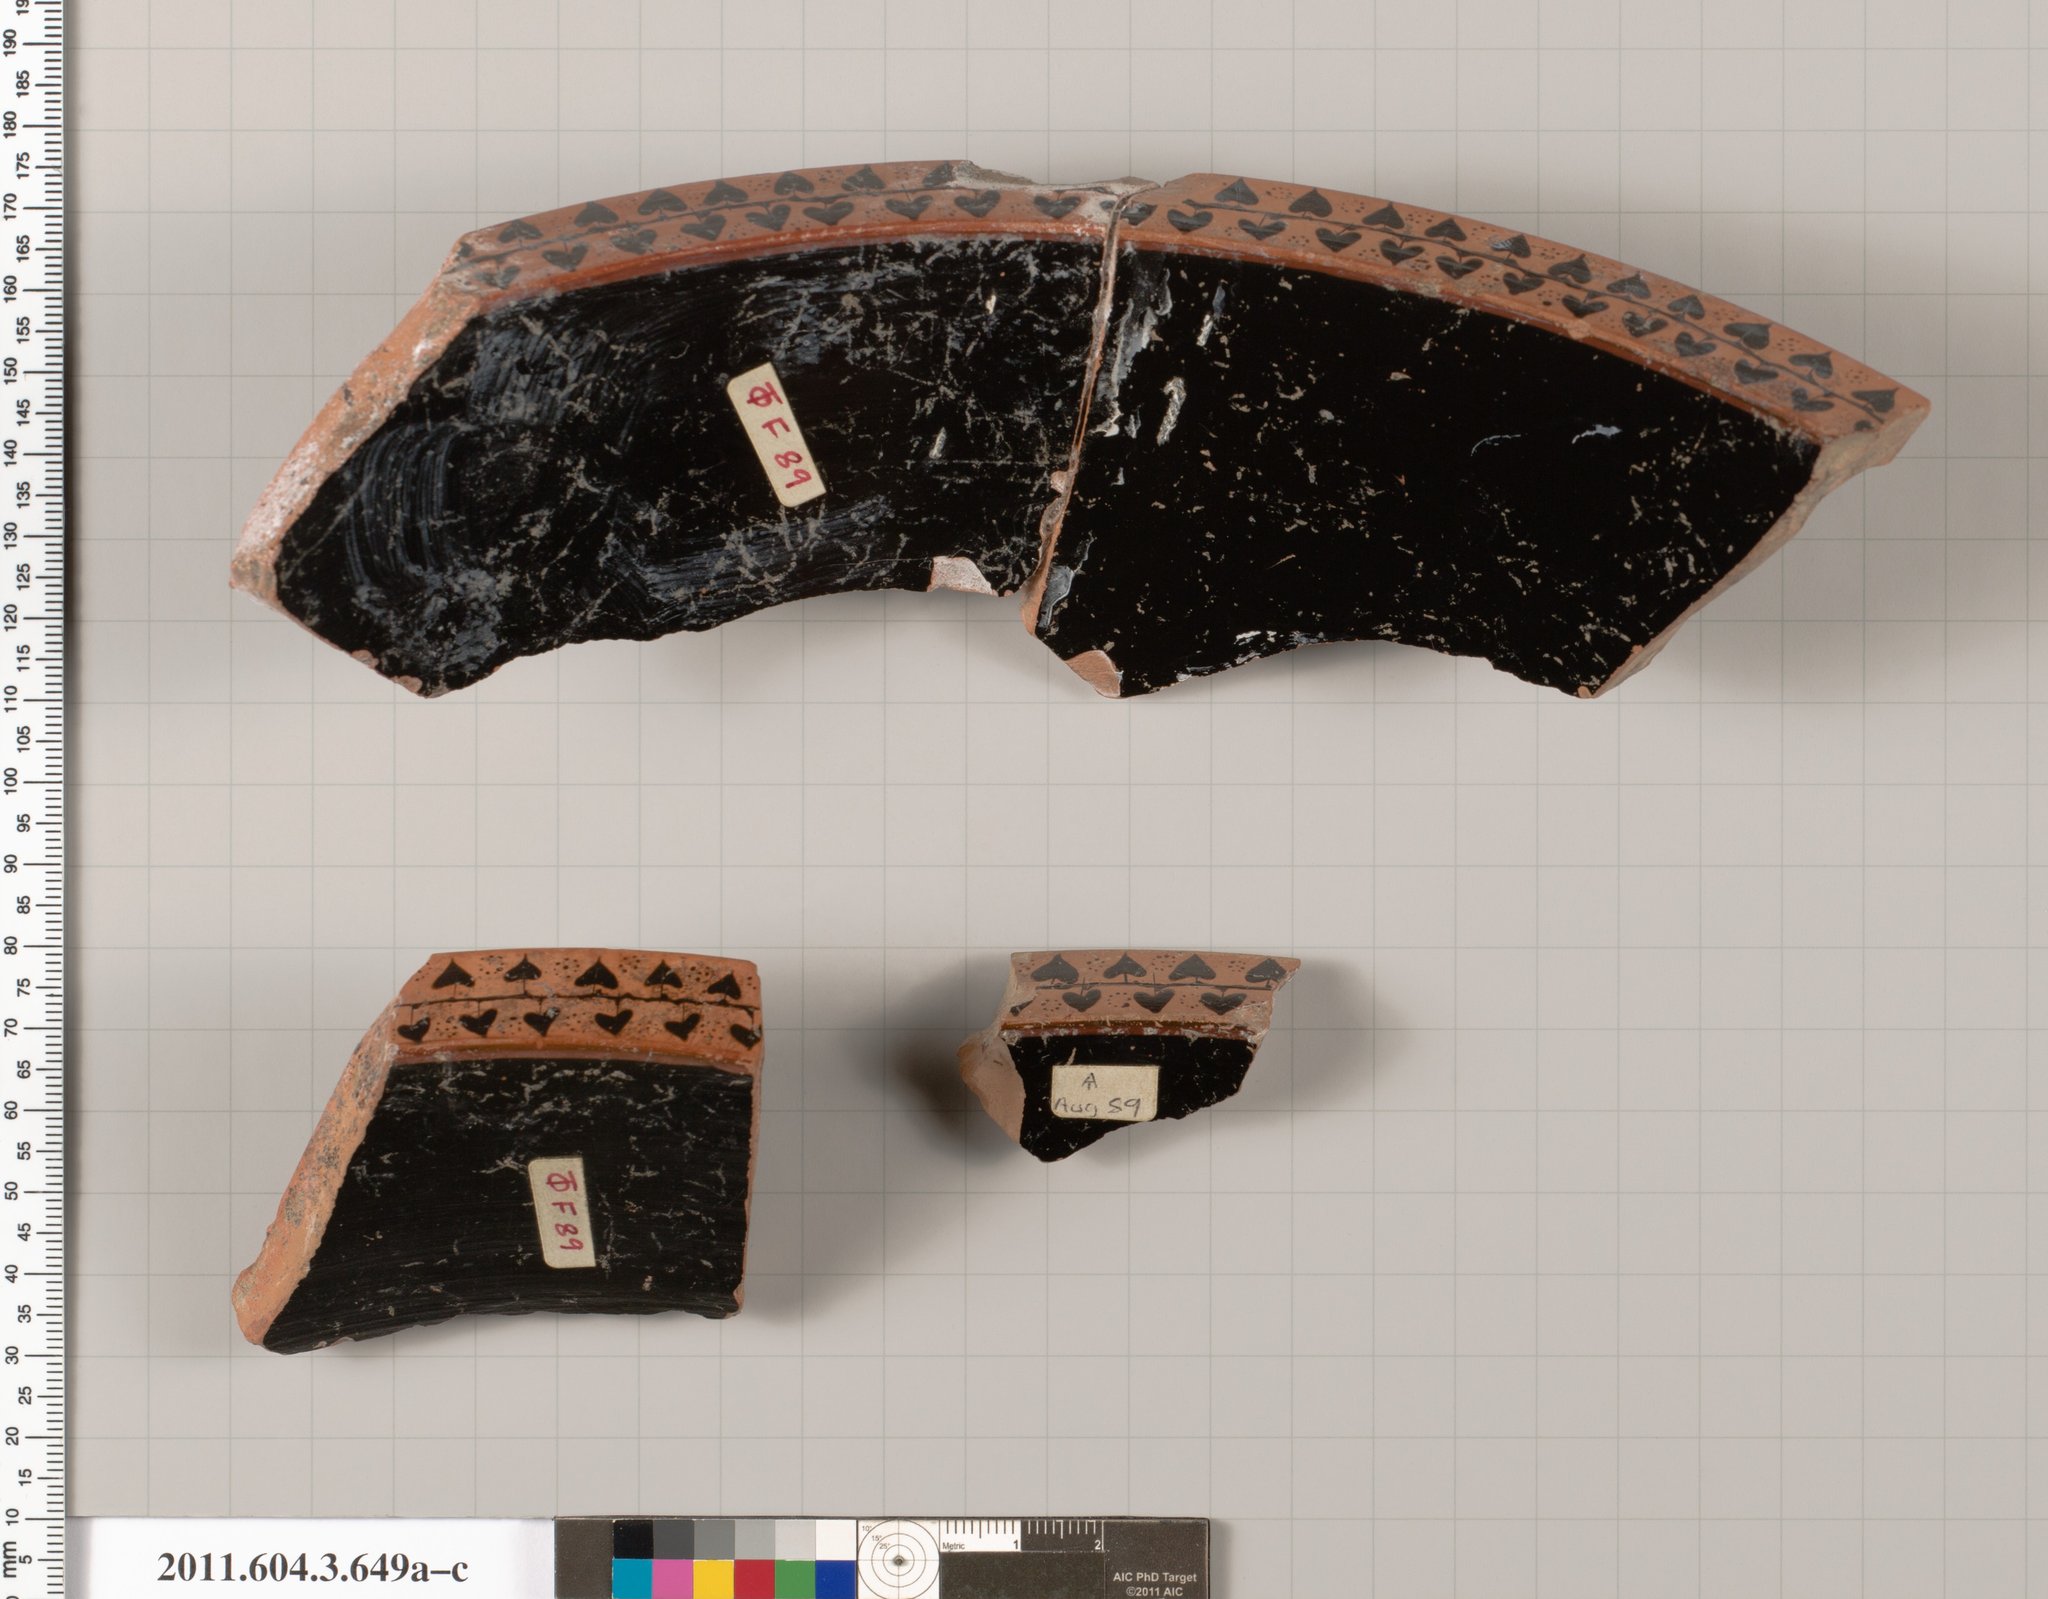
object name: volute krater fragment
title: Terracotta fragments of a volute-krater (bowl for mixing wine and water)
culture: greek, attic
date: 550-540 BCE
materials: terracotta